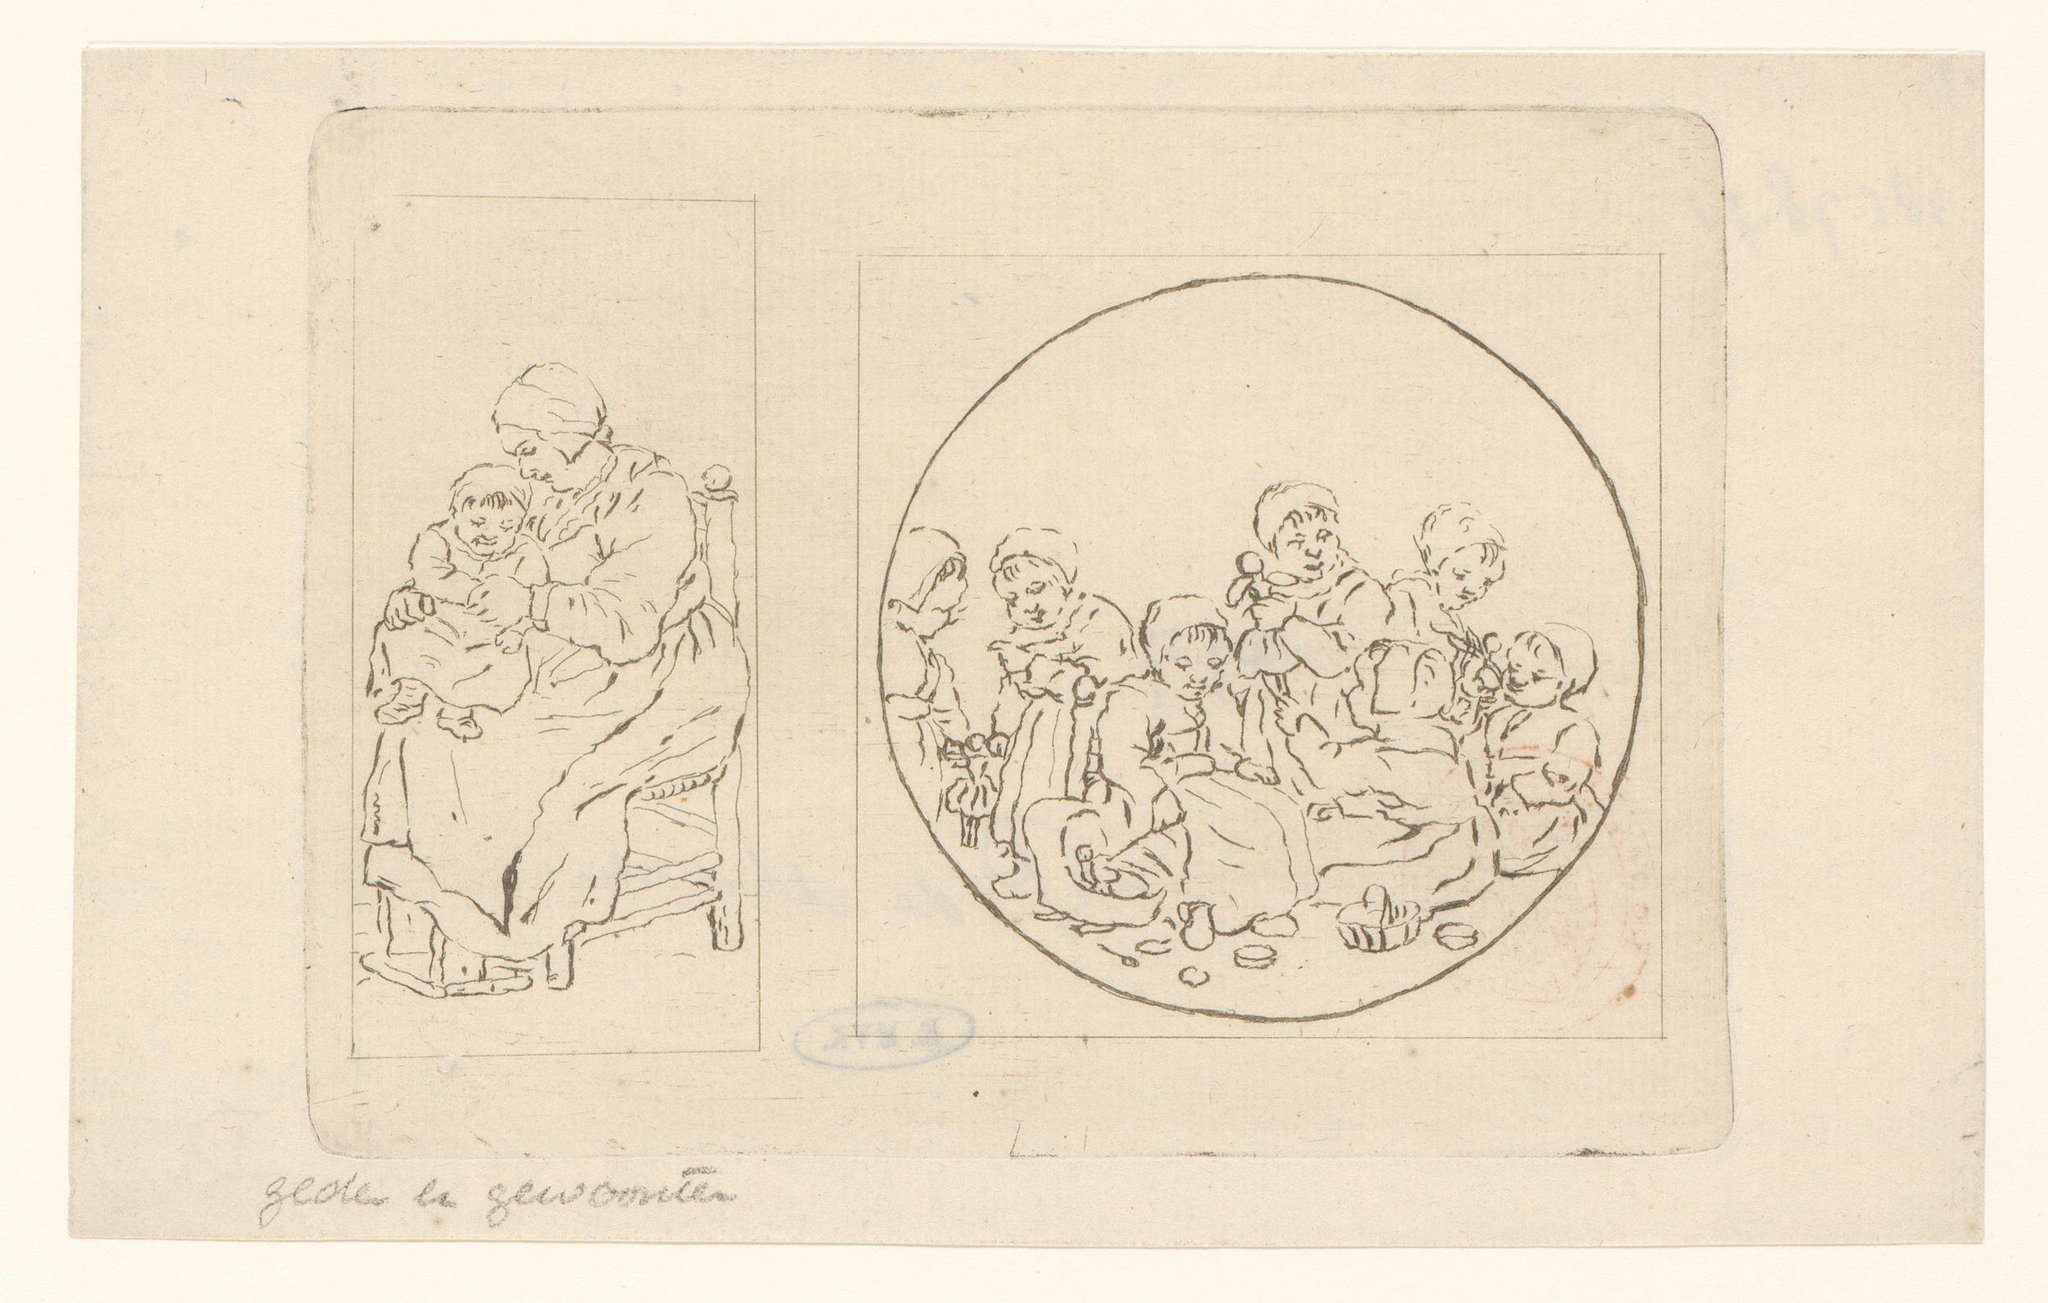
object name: book illustration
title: Zittende moeder met kind en spelende kinderen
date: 1779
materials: paper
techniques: etching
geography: leiden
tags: children's games and plays, mother and baby or young child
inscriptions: collector's mark: Lugt 240, collector's mark: Lugt 2228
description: Twee etsen gedrukt van één plaat op een niet versneden blad.